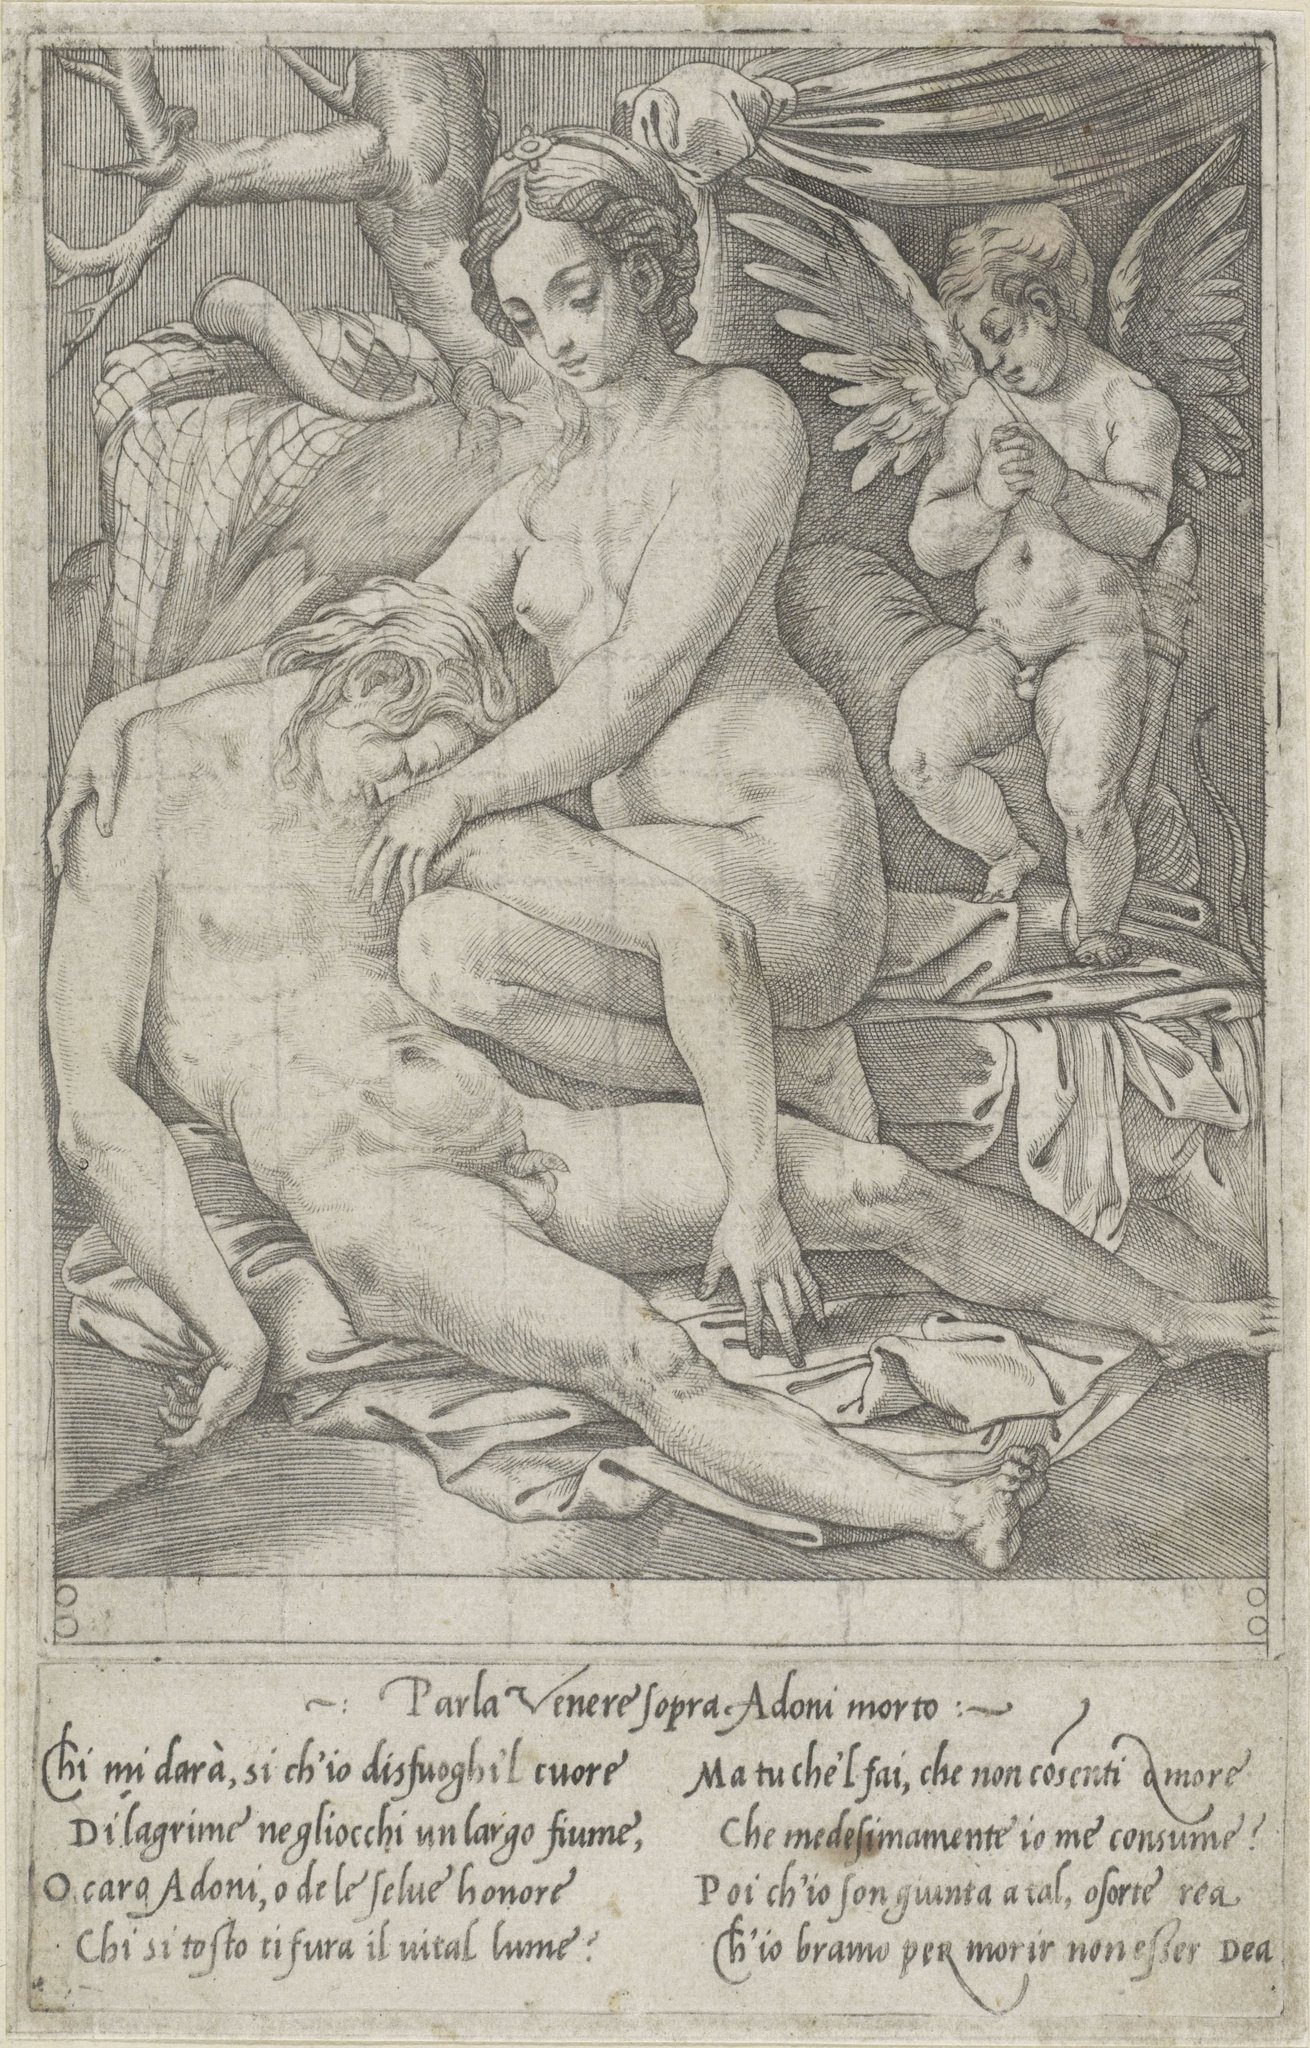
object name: print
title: Loves of the Gods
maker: giovanni jacopo caraglio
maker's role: goldsmith, print maker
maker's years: 1500-1565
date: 1515-1565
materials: paper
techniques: engraving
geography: italy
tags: death of adonis: he is killed by a boar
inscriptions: collector's mark: Lugt 240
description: De naakte Venus hurkt naast het dode lichaam van Adonis. Rechts staat Amor. In ondermarge Italiaans vers in twee kolommen.